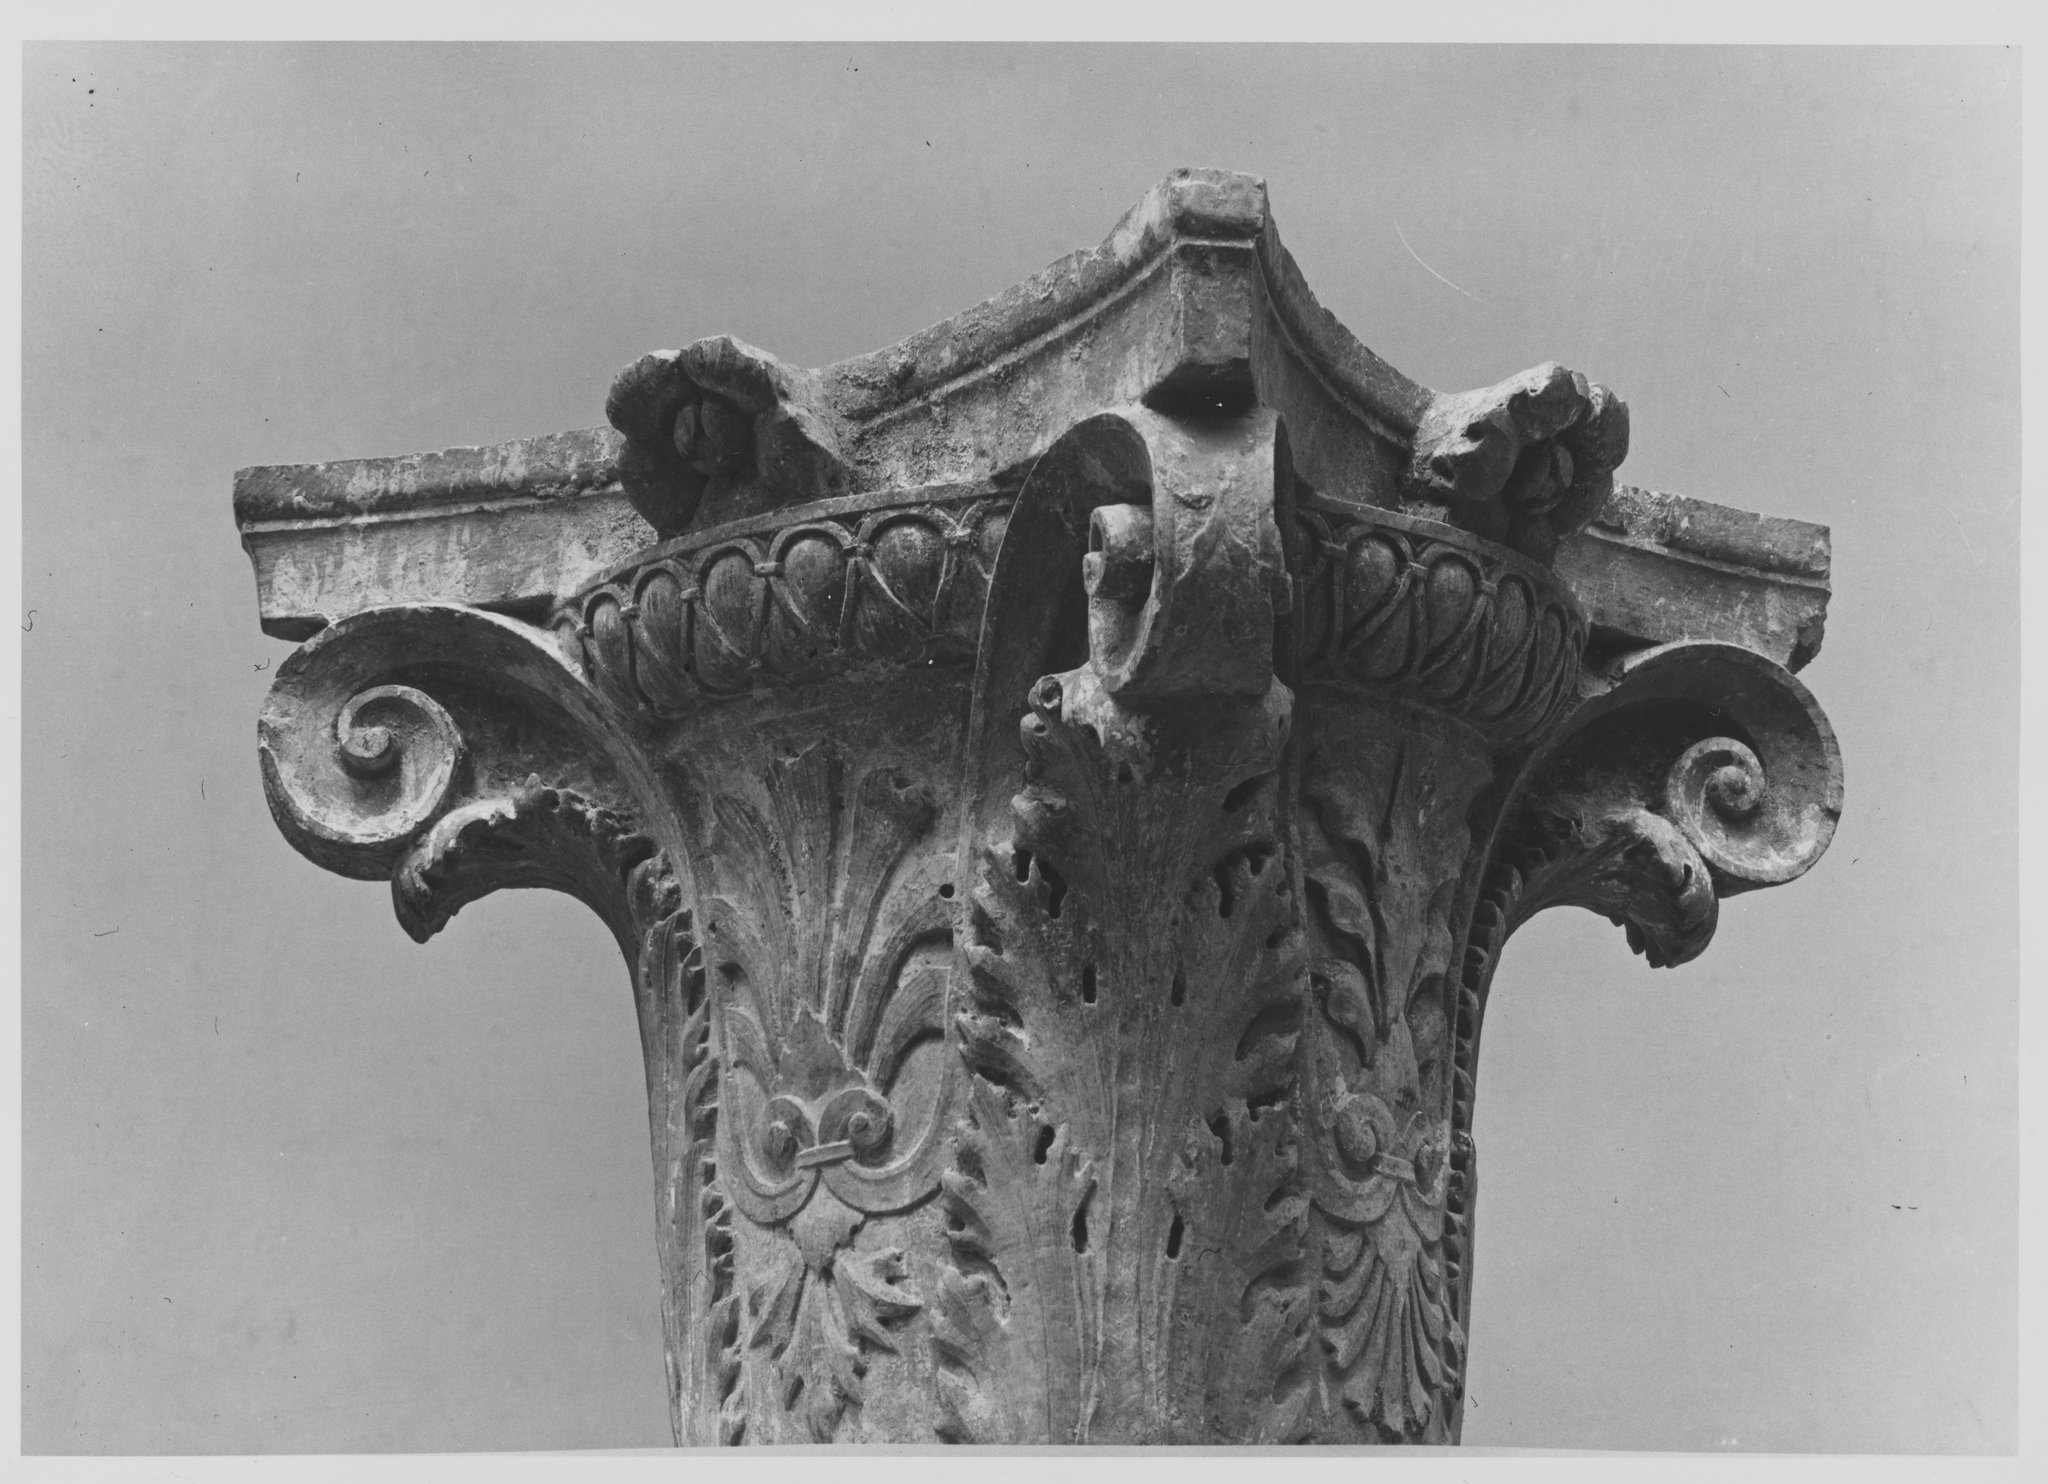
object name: capital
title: Capital (one of a series)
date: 1451-1500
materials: stone